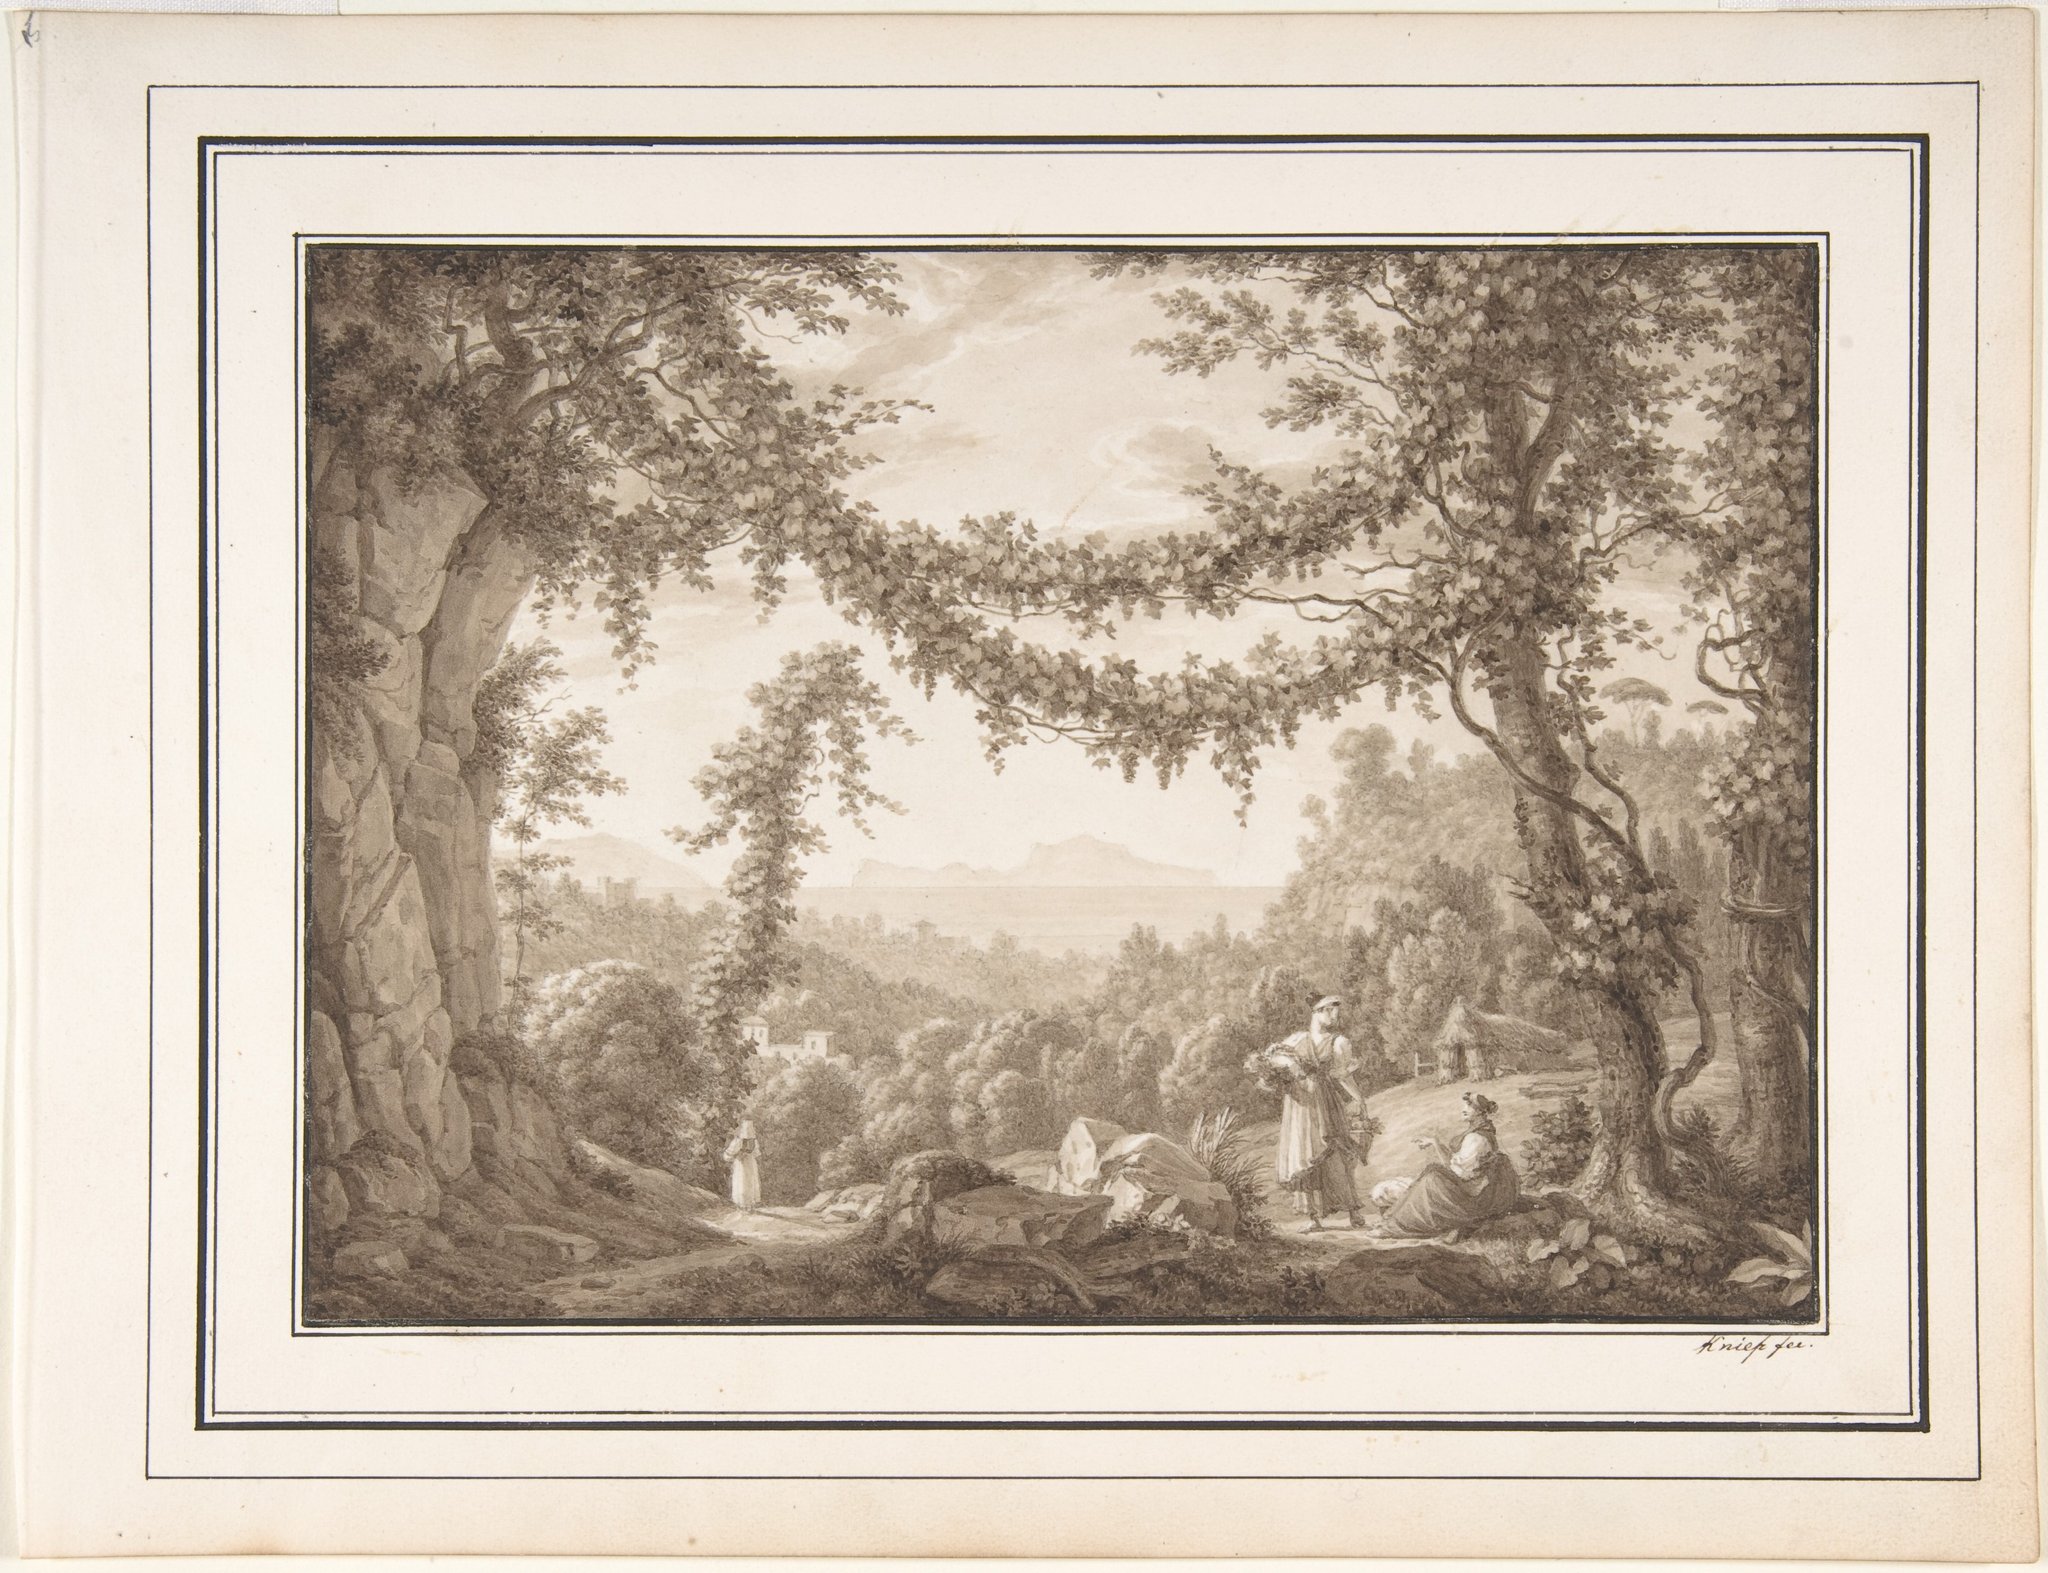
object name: drawing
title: Grape Harvest at the Gulf of Naples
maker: christoph heinrich kniep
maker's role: artist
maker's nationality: german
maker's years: 1755-1825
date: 1770-1825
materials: graphite, ink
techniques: brush, pen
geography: italy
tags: women,trees